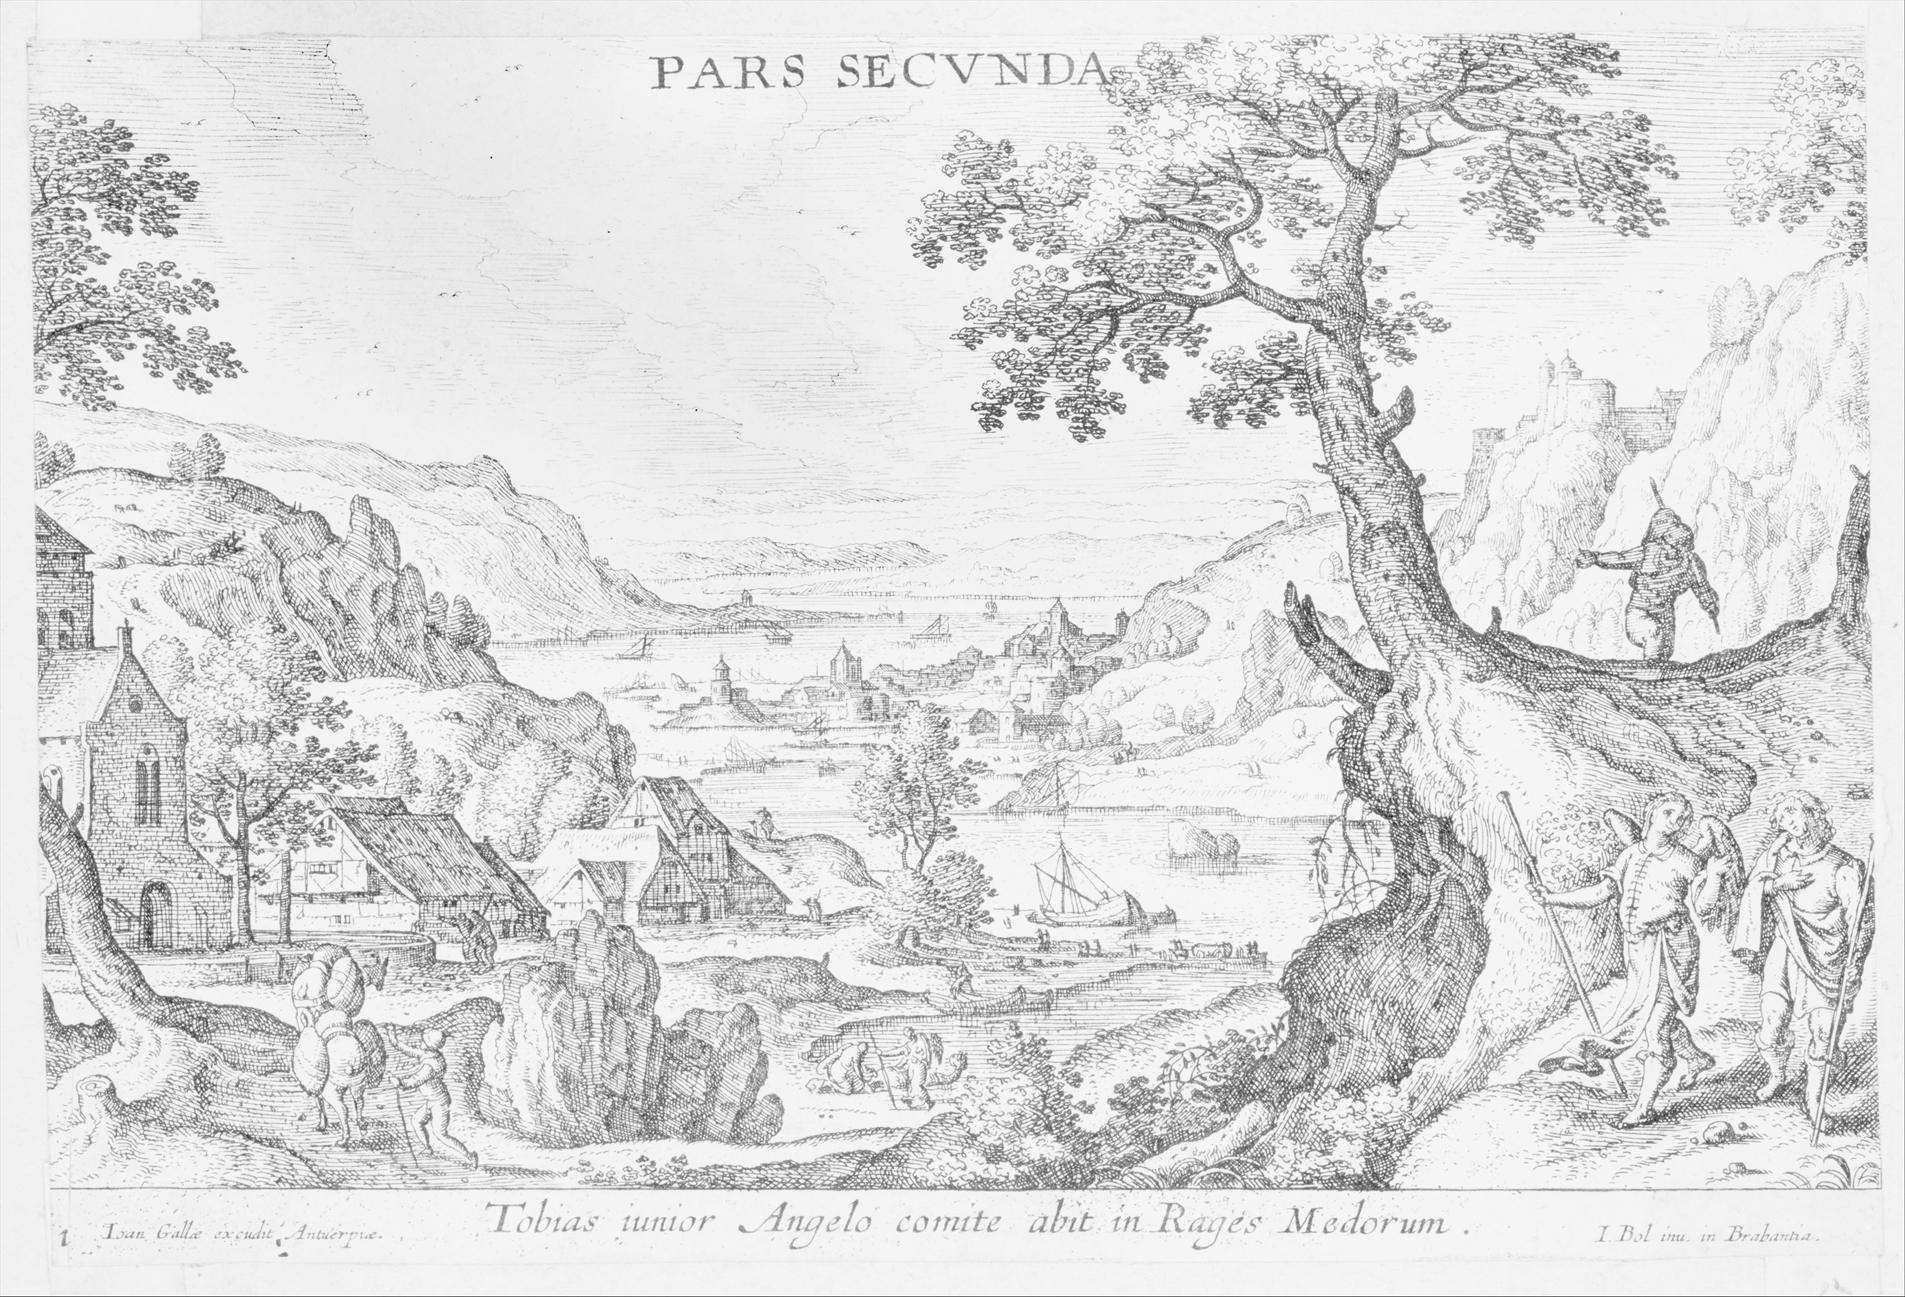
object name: print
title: Pars Secunda from Topographia Variarum Regionum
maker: hans bol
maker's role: artist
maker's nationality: netherlandish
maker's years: 1534-1593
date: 1601-1700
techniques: etching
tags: landscapes